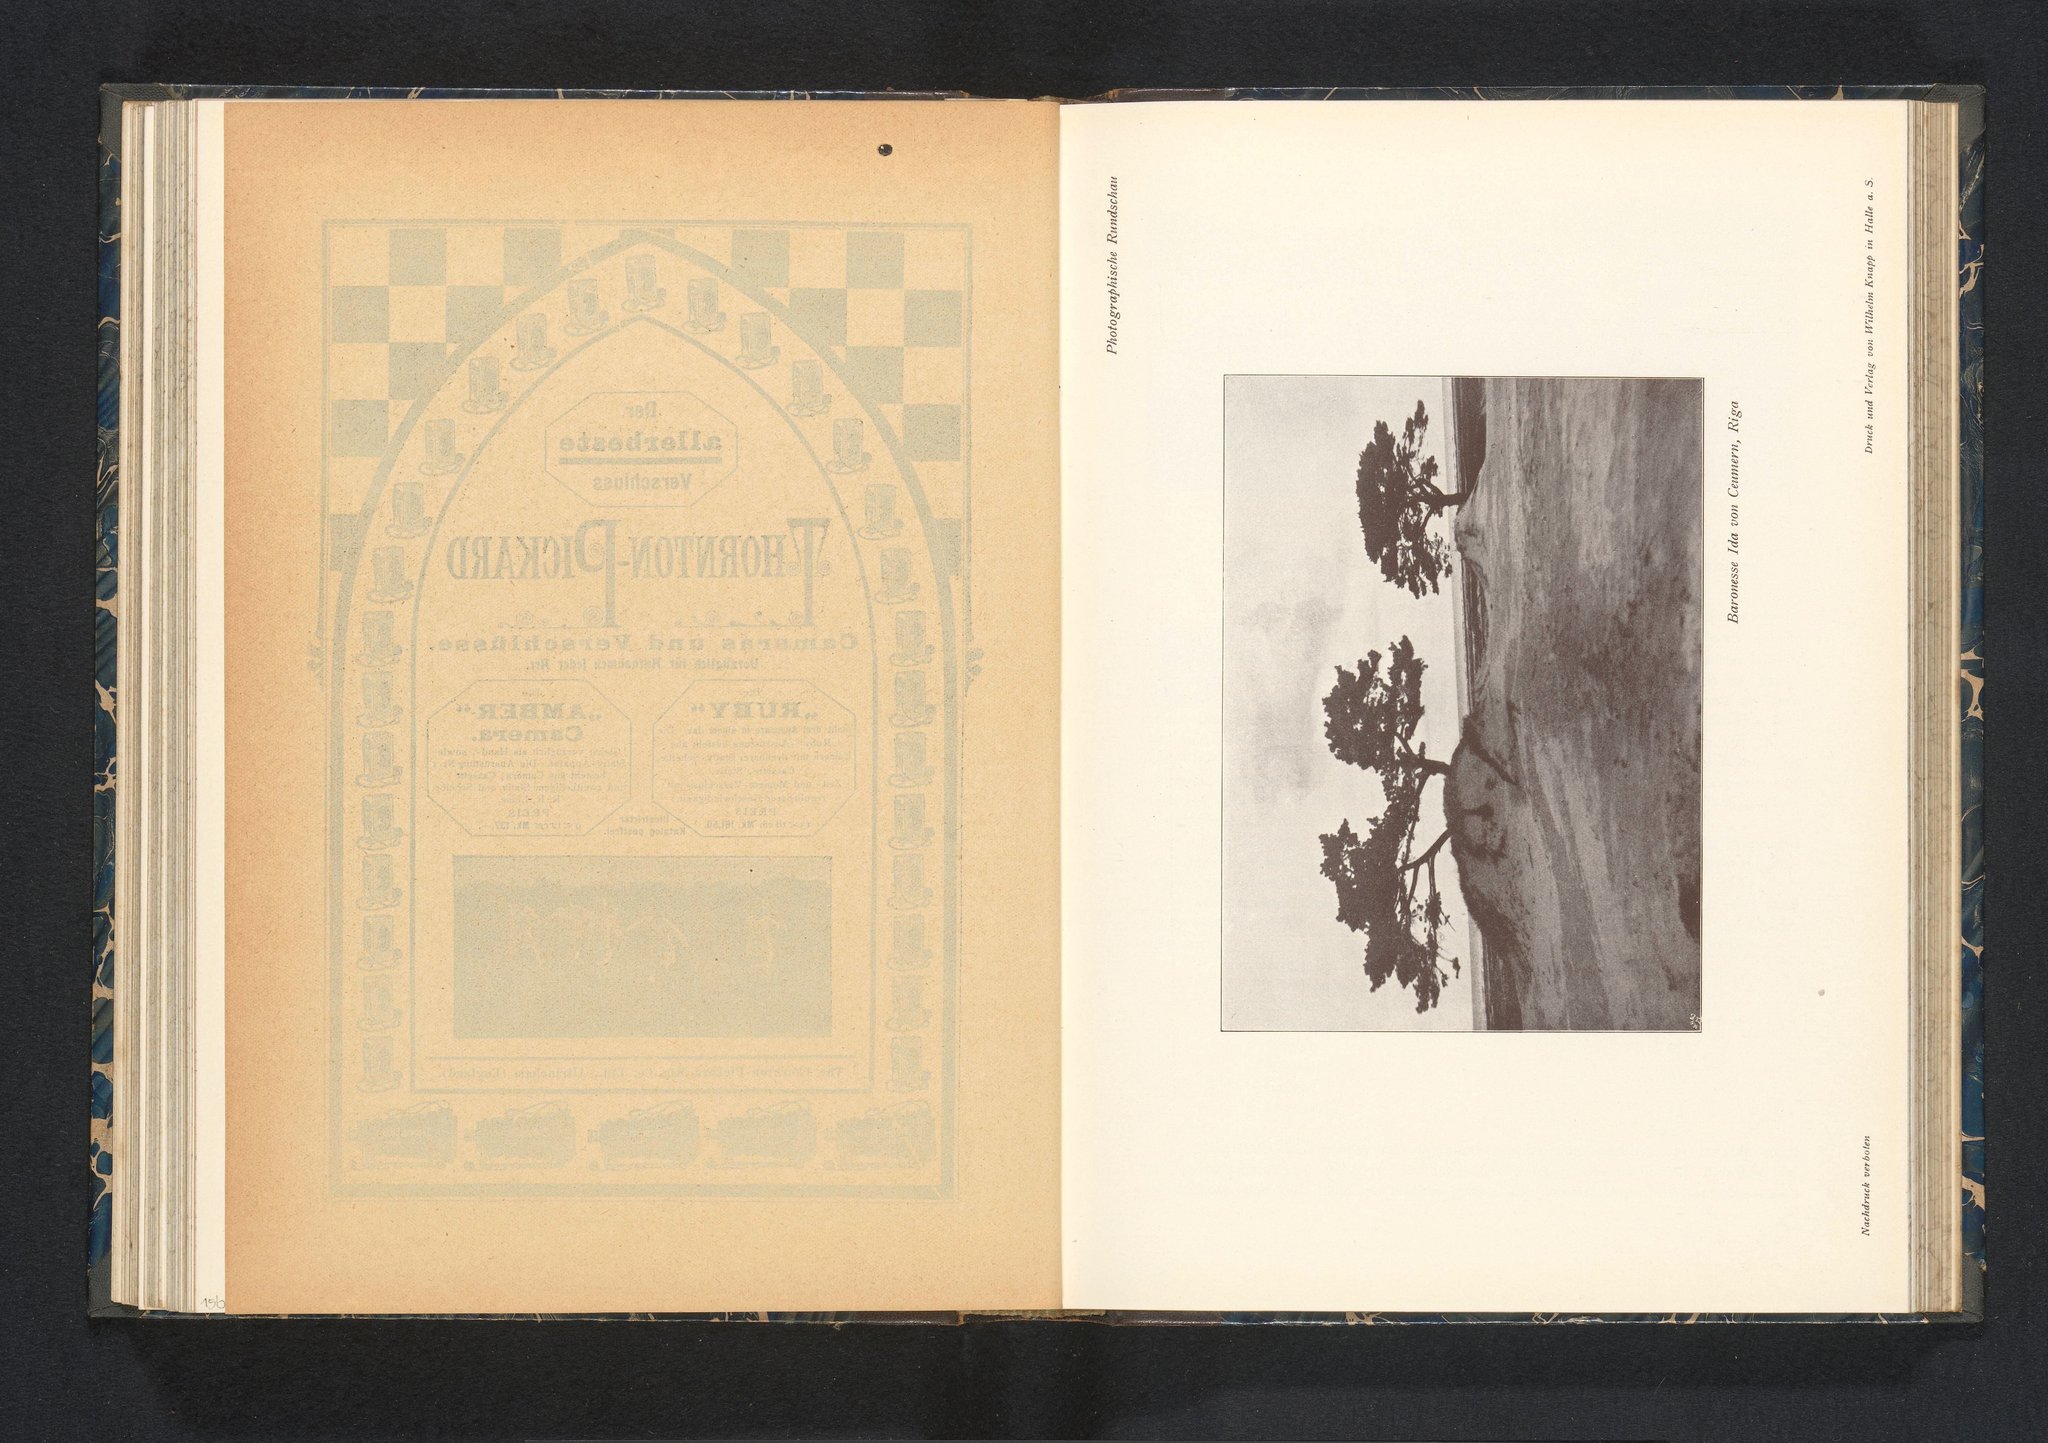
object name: photomechanical print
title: Landschap met drietal bomen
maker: ida von ceumern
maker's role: barones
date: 1896-1901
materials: paper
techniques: autotype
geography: berlin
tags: trees, landscapes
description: Prent op zevende ongenummerde pagina na pagina 196.